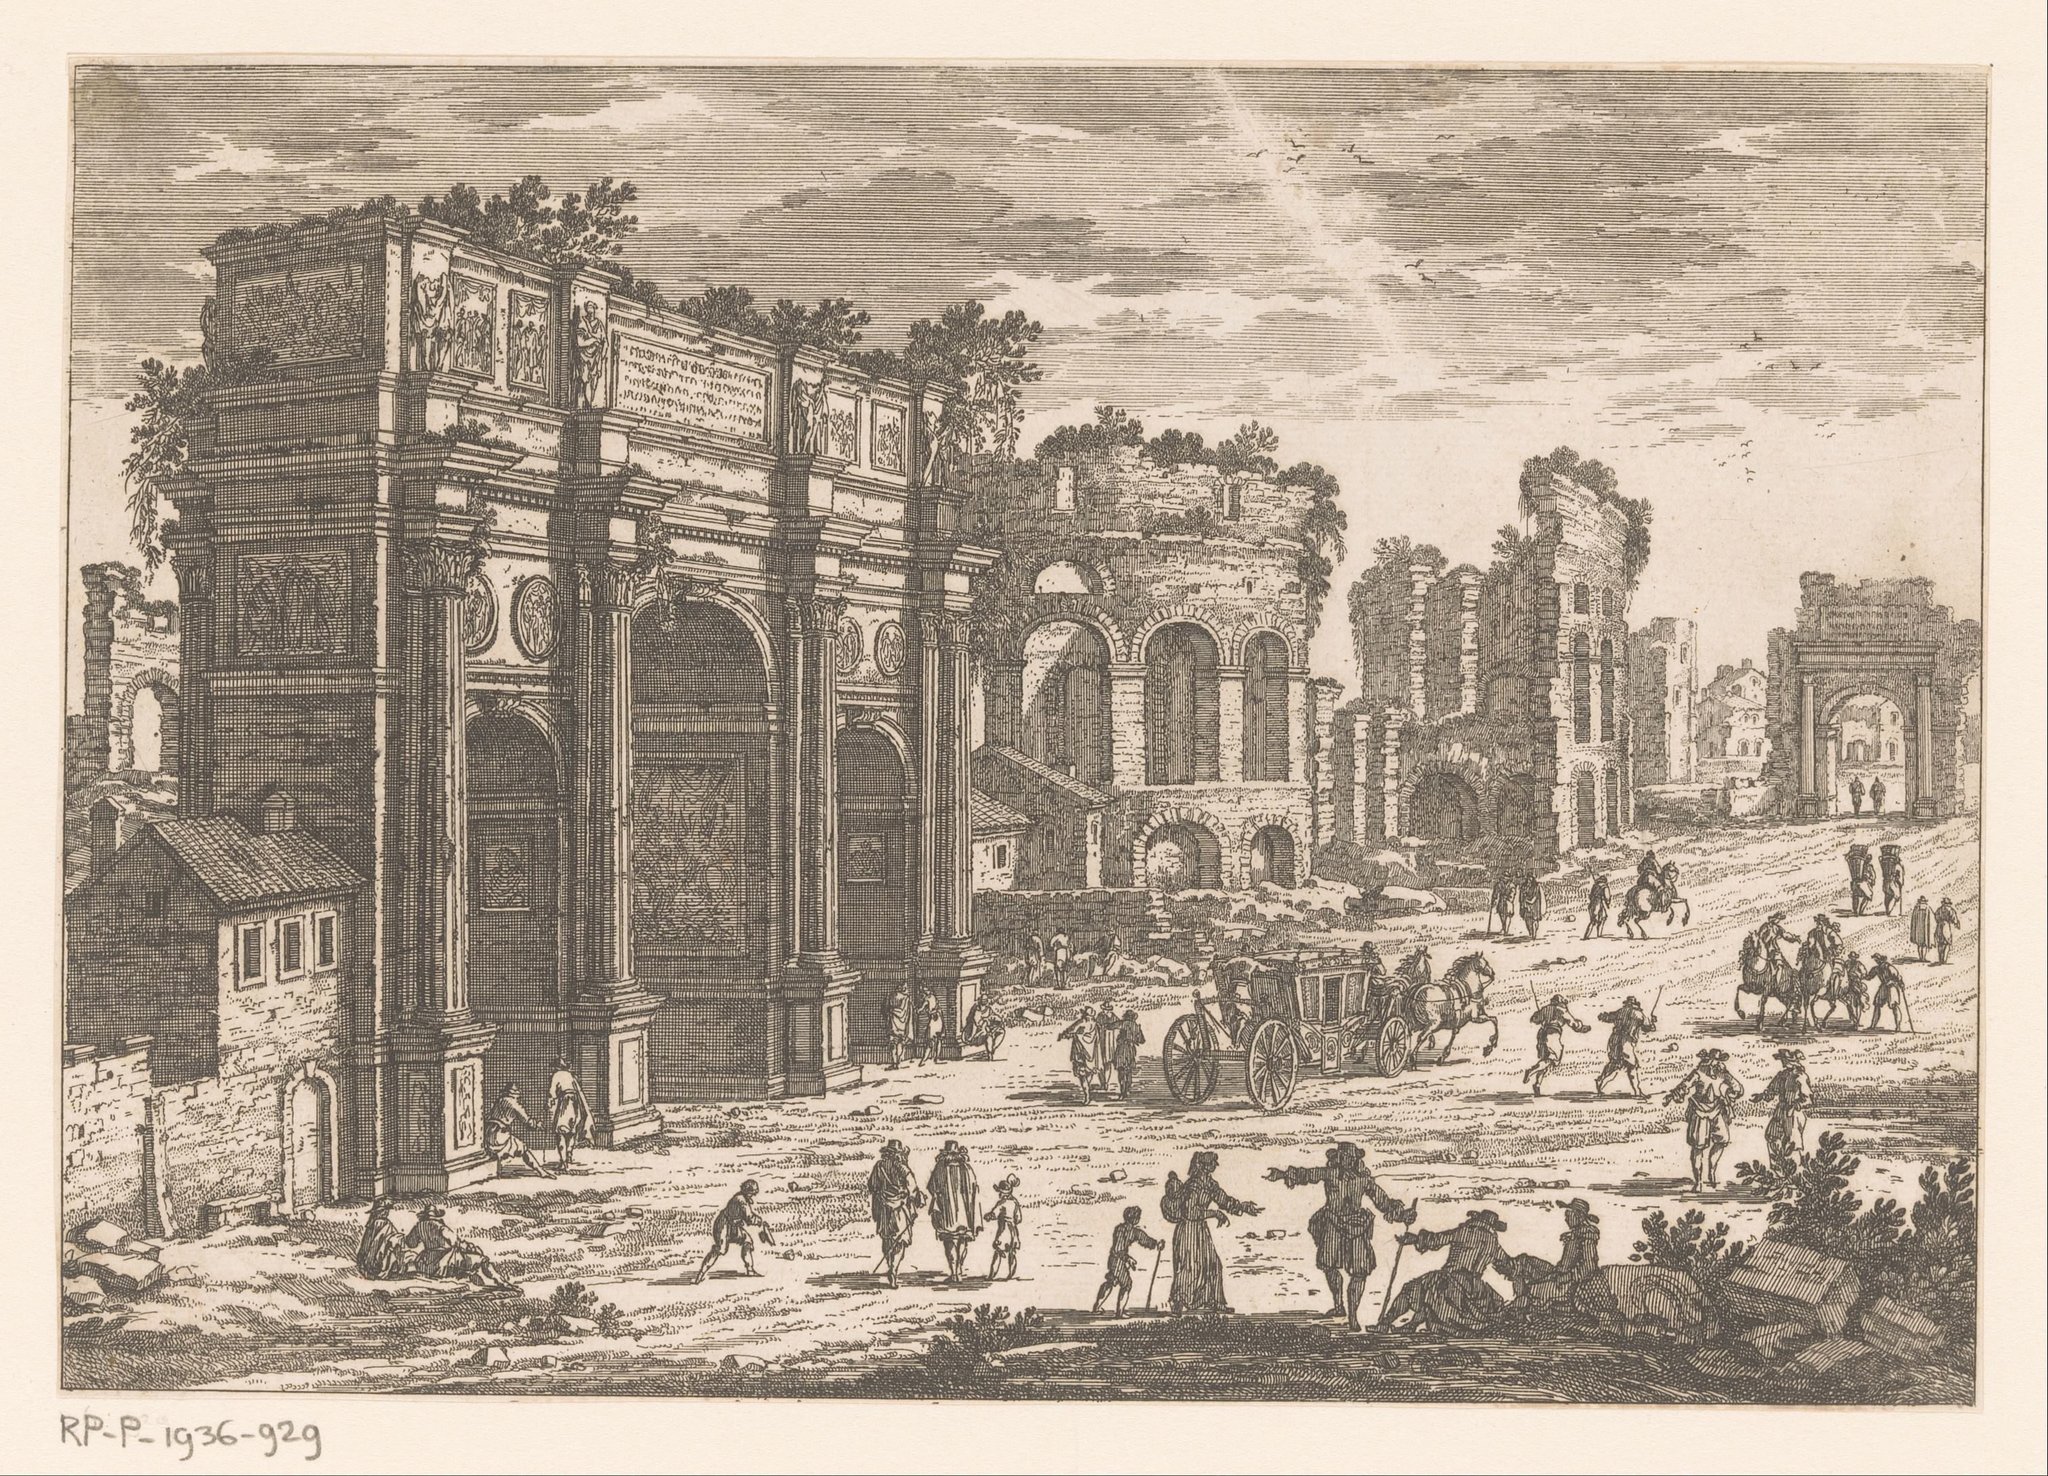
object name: print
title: Gezicht op ruïnes in Rome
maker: adam perelle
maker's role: draughtsman, print maker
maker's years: 1638-1695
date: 1650-1695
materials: paper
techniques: engraving, etching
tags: ruin of a building ~ architecture, landscape with ruins (+ city(-scape) with figures, staffage), rome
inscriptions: collector's mark: Lugt 2228